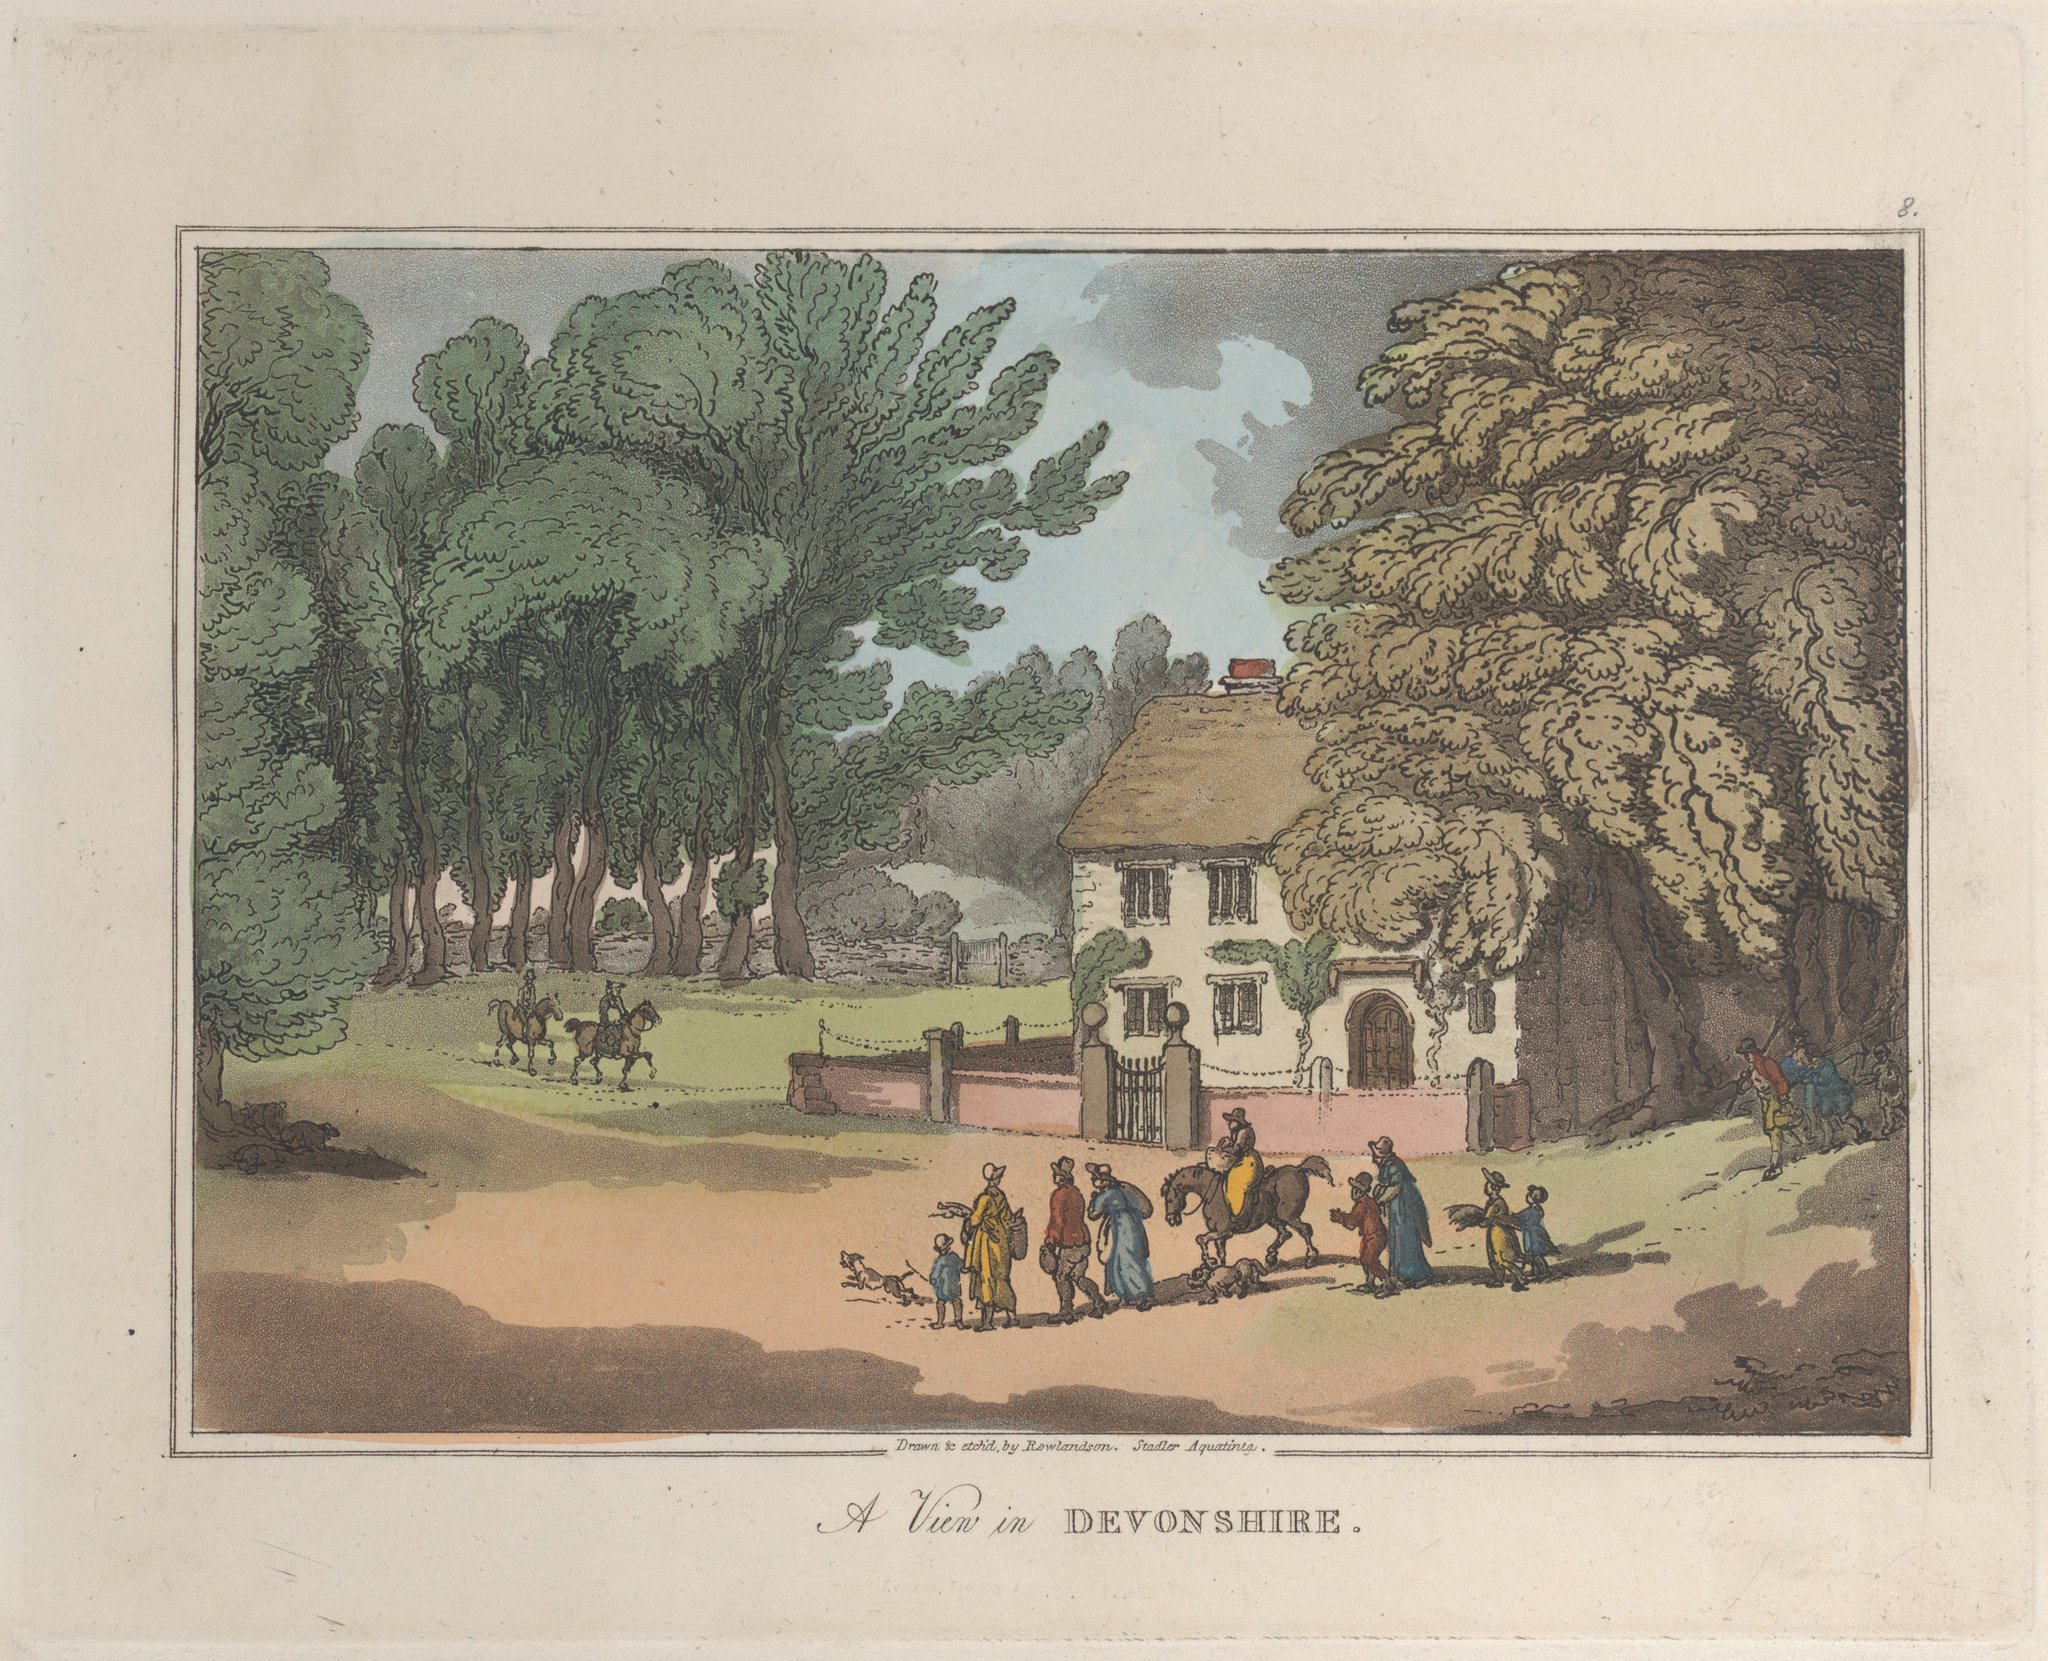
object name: print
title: A View in Devonshire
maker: thomas rowlandson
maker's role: artist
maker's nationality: british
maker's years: 1757-1827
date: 1822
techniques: aquatint, etching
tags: houses,landscapes